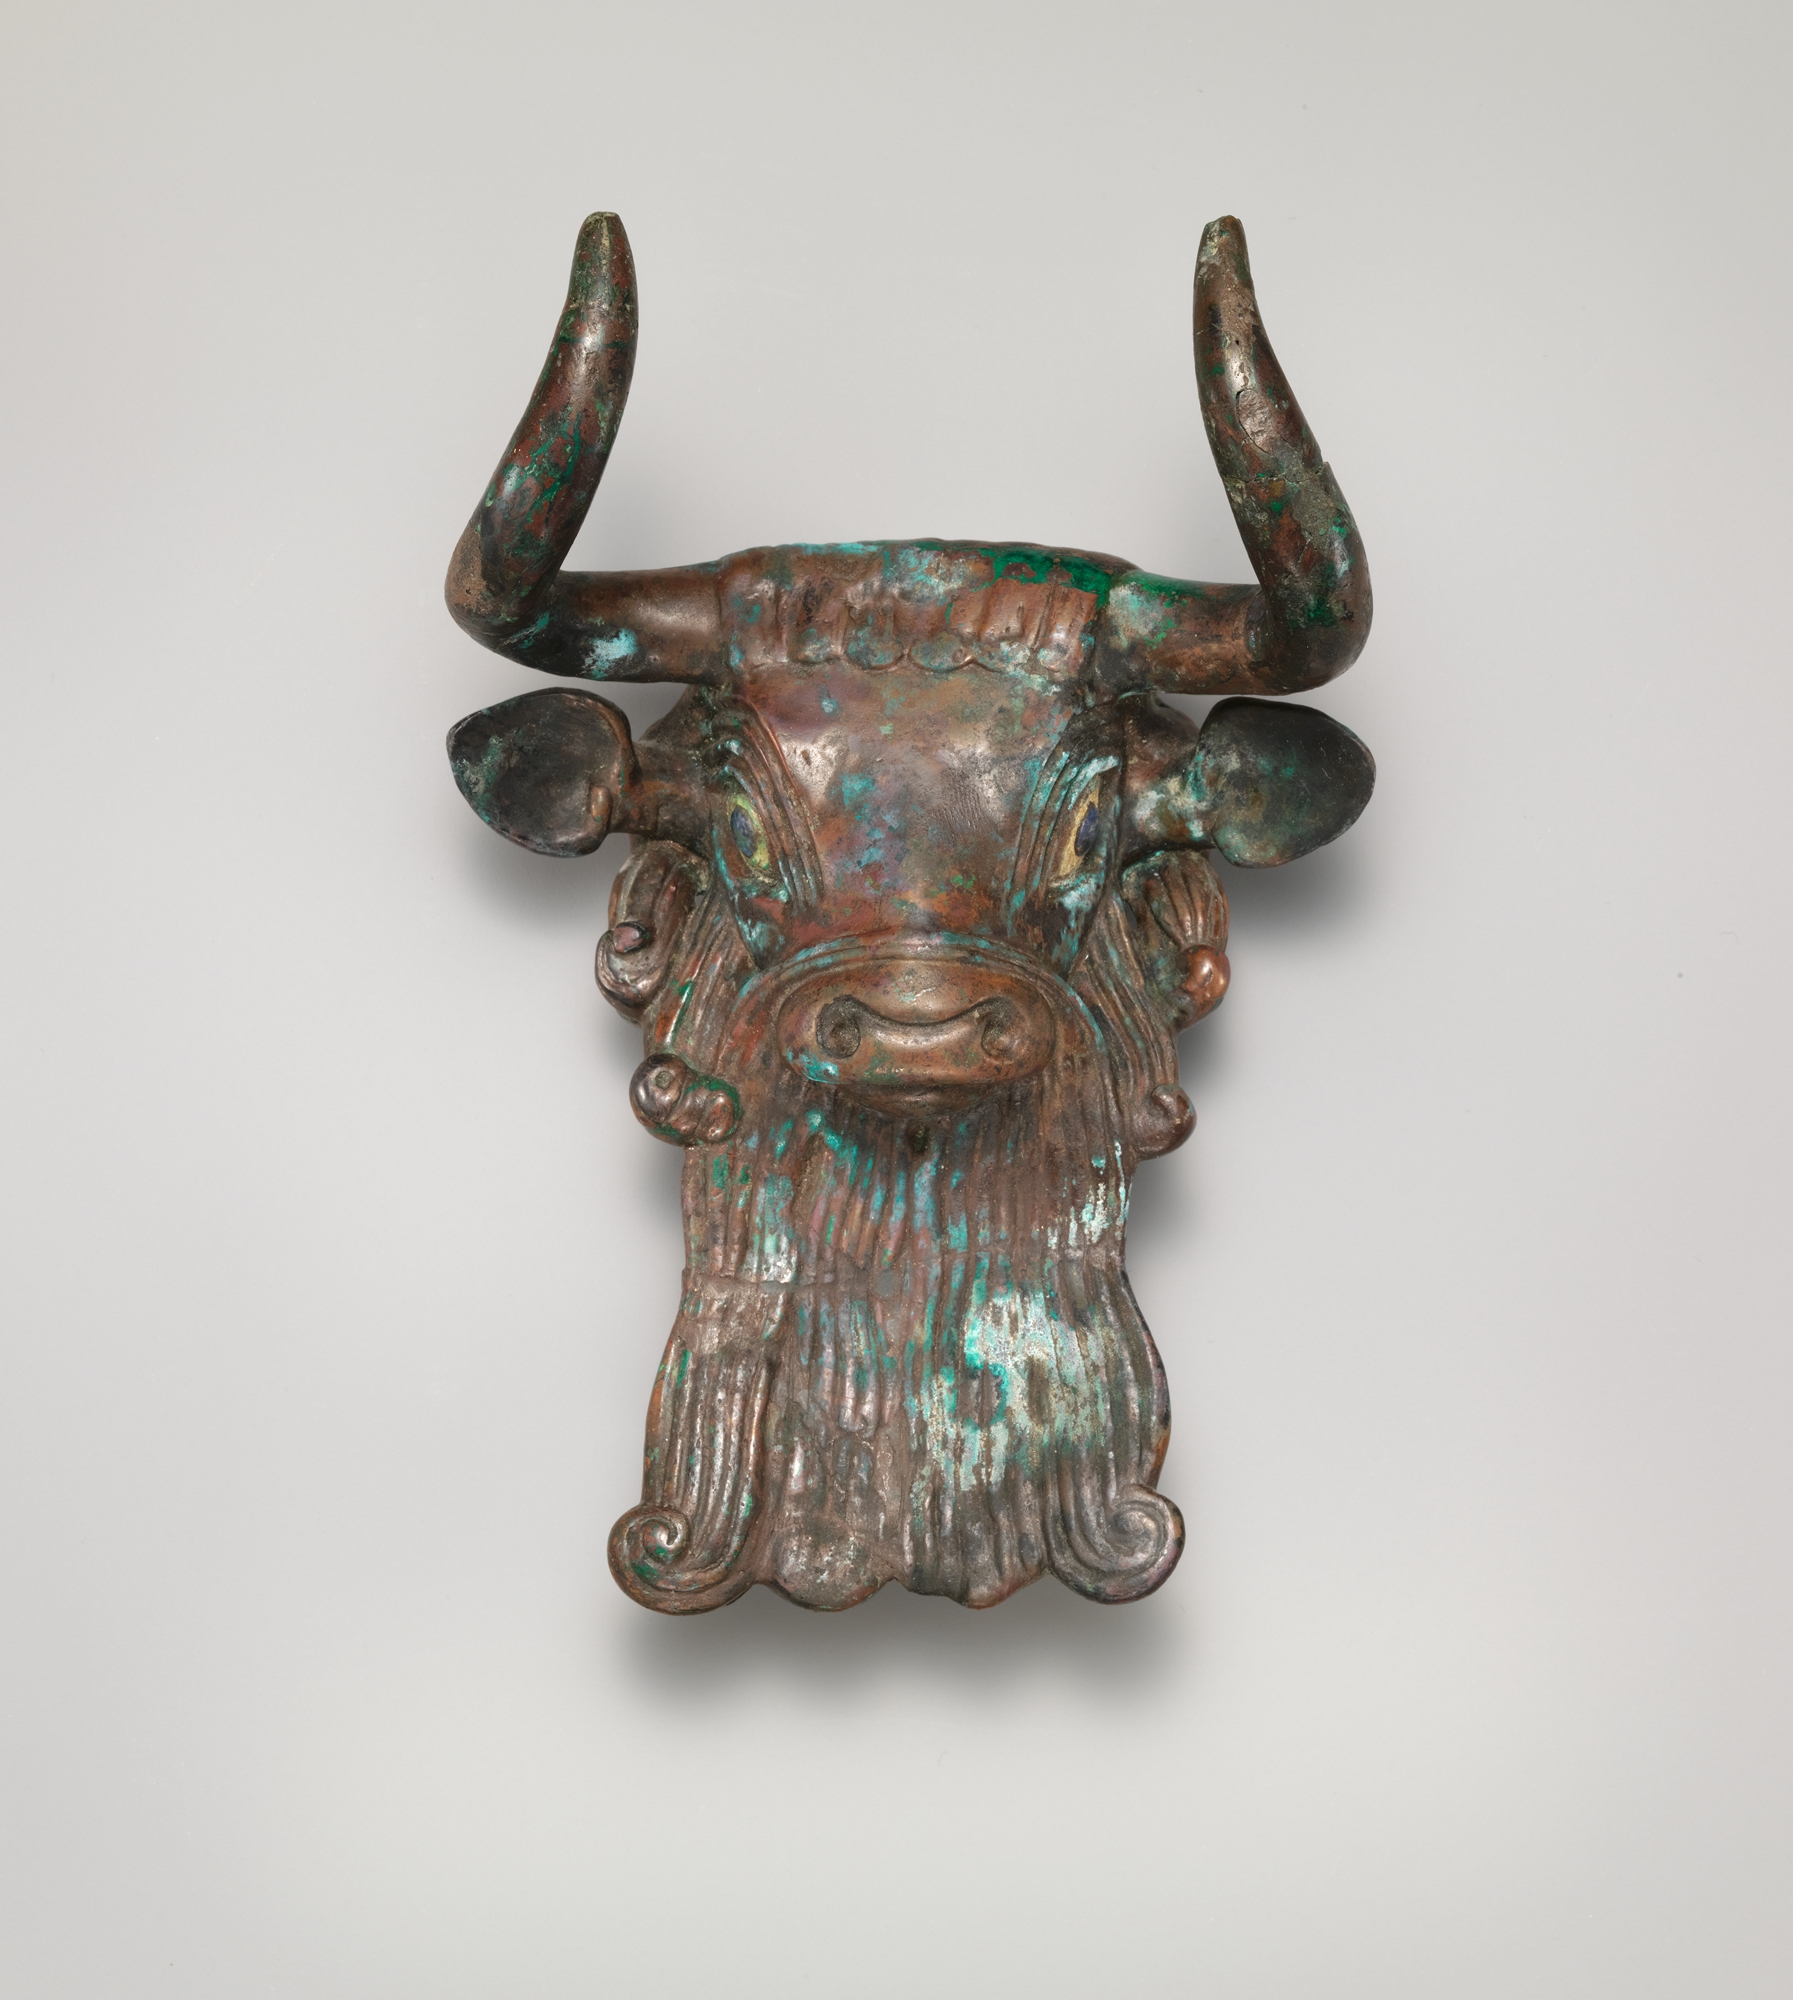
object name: lyre ornament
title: Bull's head ornament for a lyre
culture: sumerian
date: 2600-2350 BCE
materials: bronze, lapis lazuli, shell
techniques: inlay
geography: mesopotamia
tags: bulls